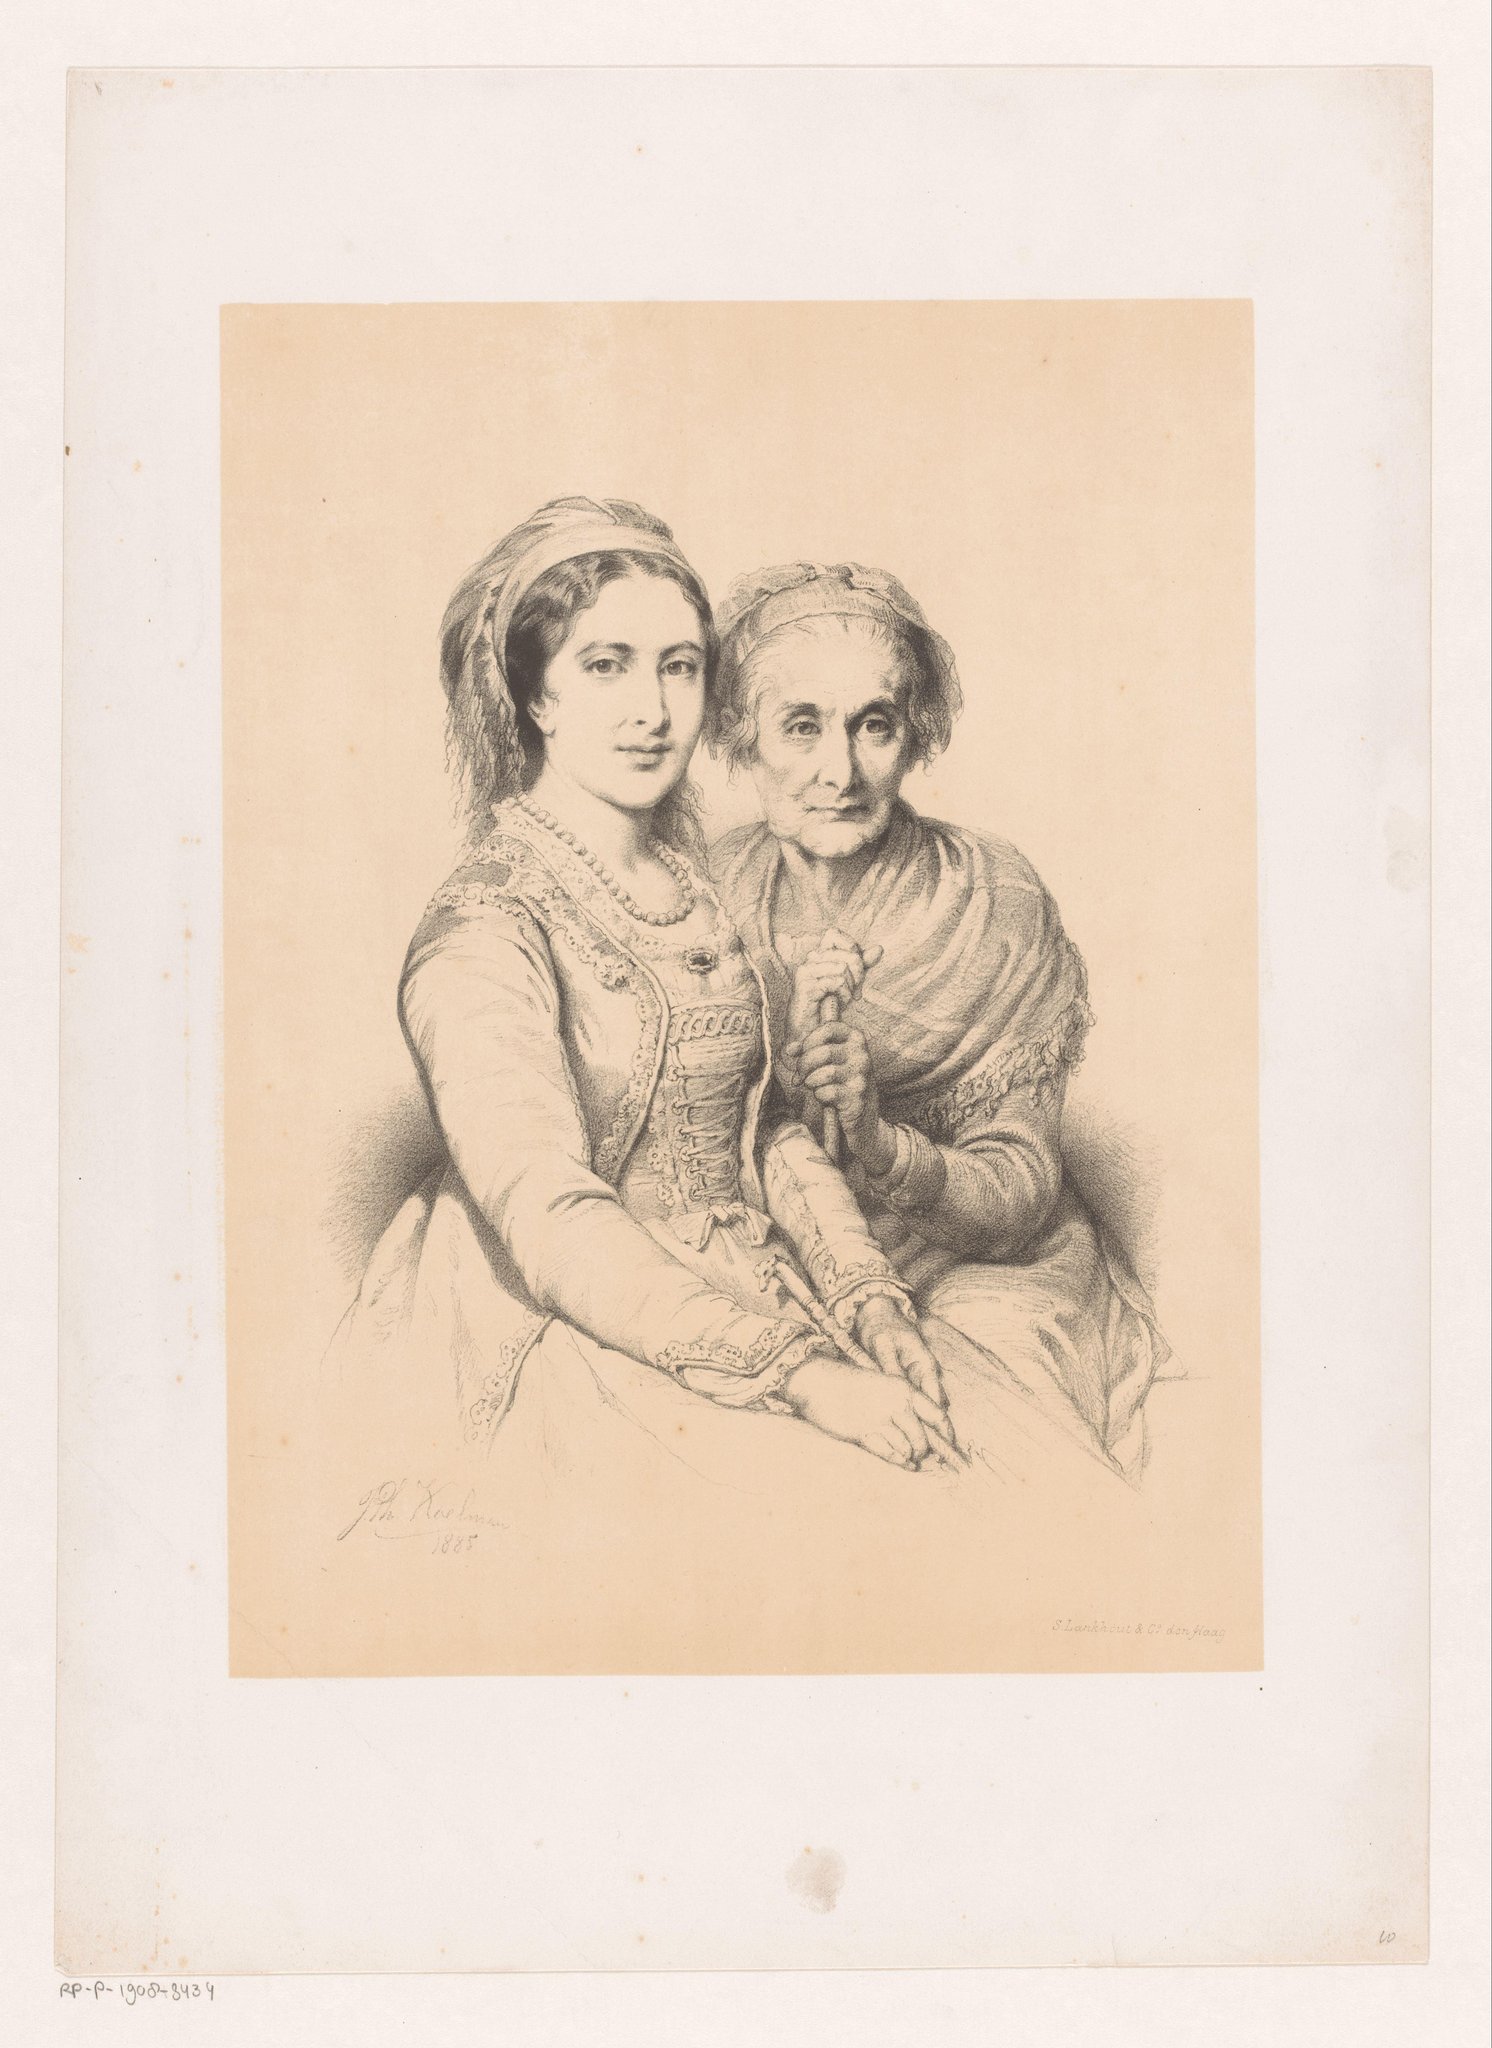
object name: print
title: Dubbelportret van een oude en jonge vrouw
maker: johan philip koelman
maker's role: draughtsman, painter, print maker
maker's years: 1818-1893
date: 1885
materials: paper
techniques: tone lithography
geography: the hague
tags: adolescent, young woman, maiden, anonymous historical persons portrayed in a double portrait - bb - woman, walking-stick, staff, old woman, parasol, sunshade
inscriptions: collector's mark: Lugt 2228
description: De vrouwen zitten dicht bij elkaar. De oude vrouw steunt op een wandelstok. De jonge vrouw heeft een parasol in haar handen met op het uiteinde een hondenkop.